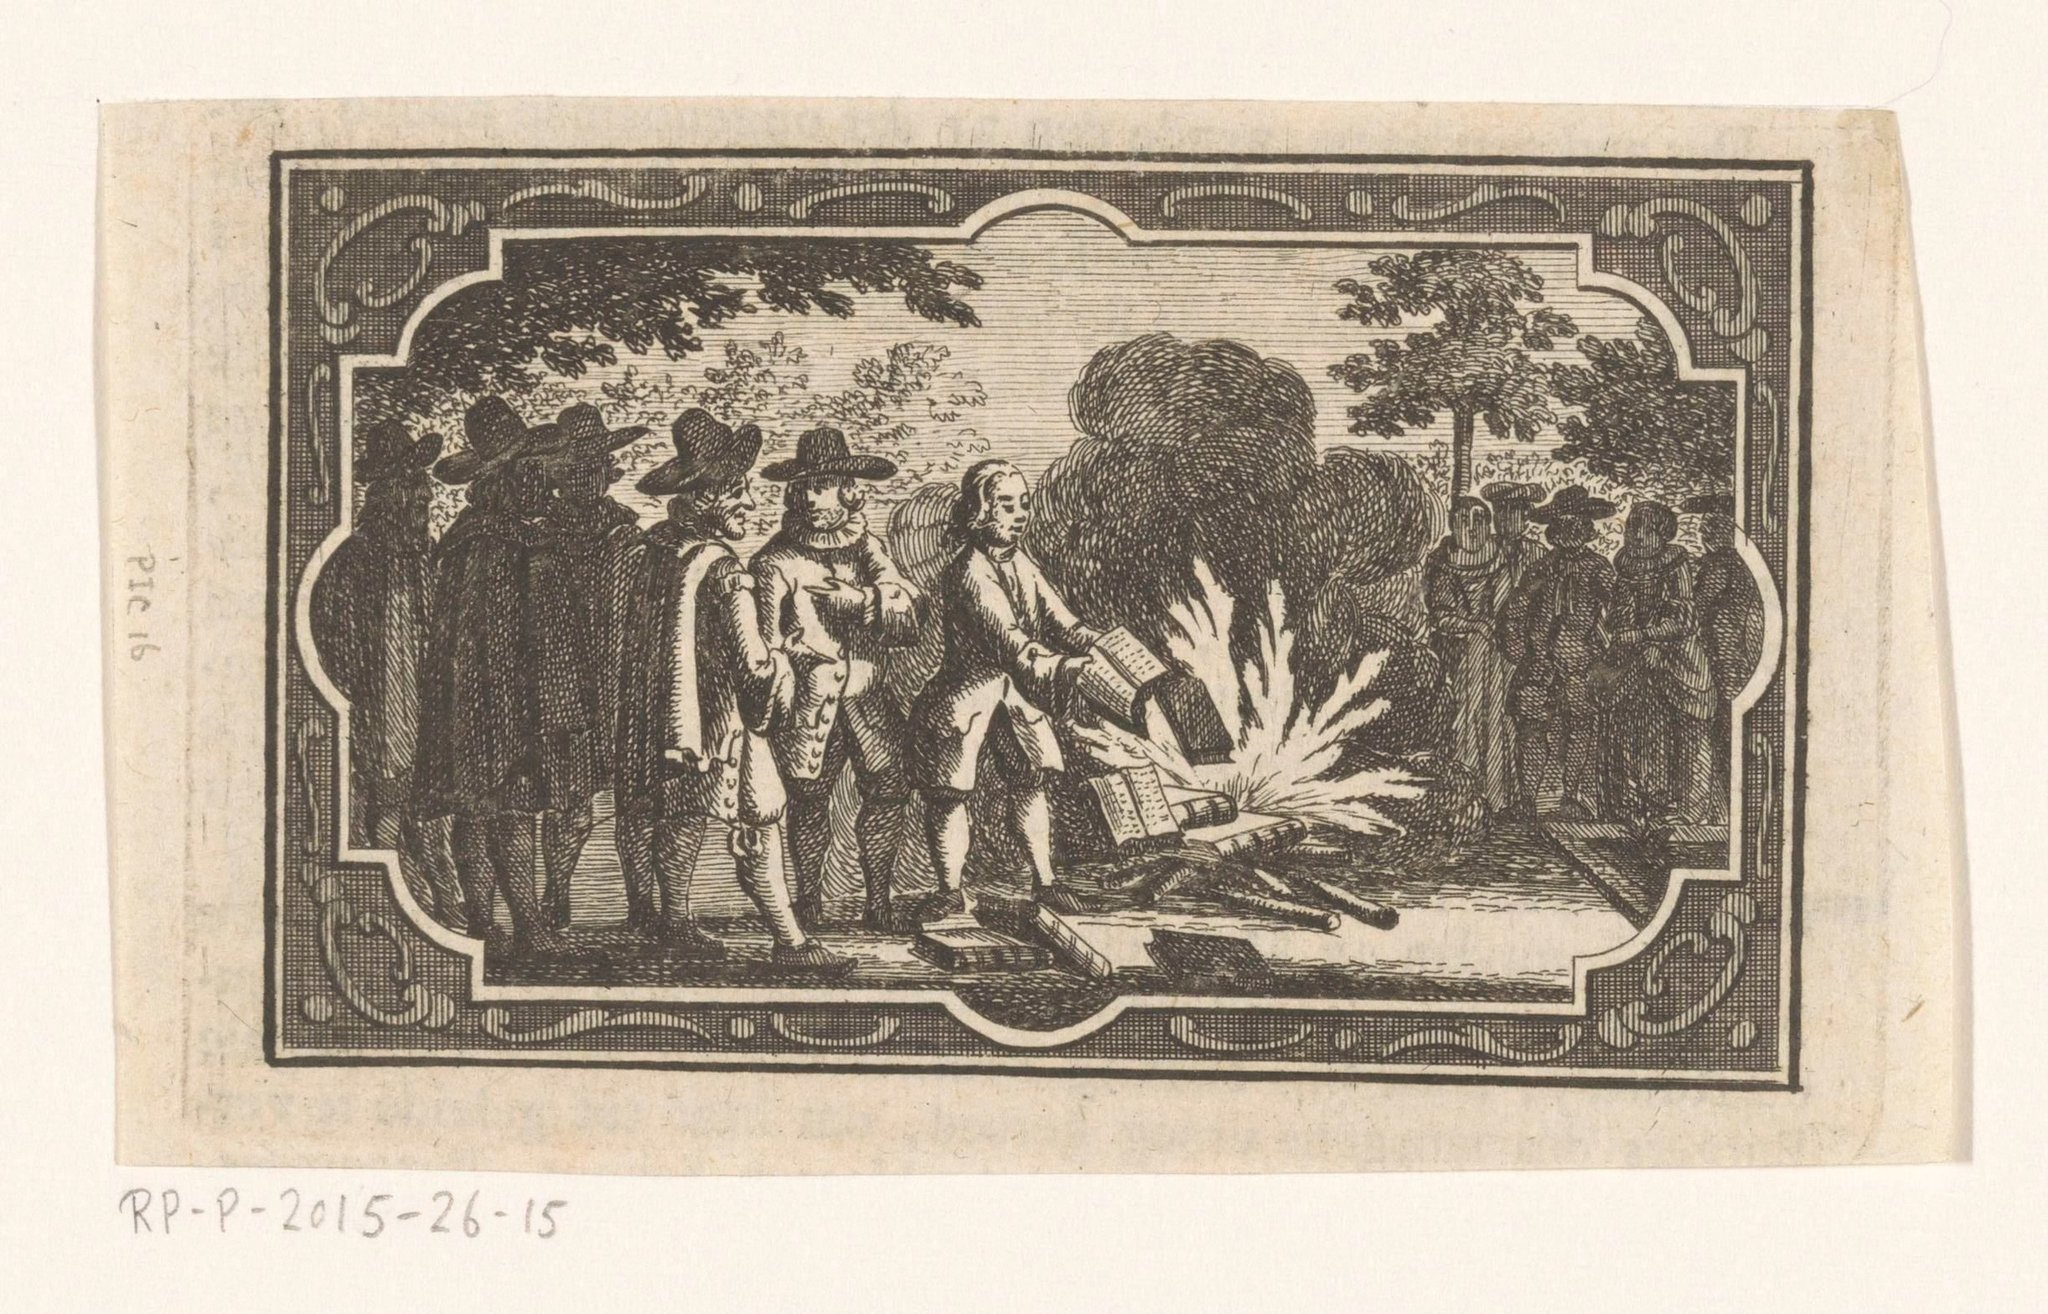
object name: book illustration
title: Boekverbranding van De vera Religione van Johannes Volkelius in de Amsterdamse Stadstimmertuin in 1642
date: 1780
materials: paper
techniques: engraving, etching, letterpress printing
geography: amsterdam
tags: burning of books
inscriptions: collector's mark: Lugt 4779, collector's mark: Lugt 2228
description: Prent gebruikt in: Staatkundige Historie van Holland. Amsterdam: B. Mourik, 1780, dl. 48, p. 8.